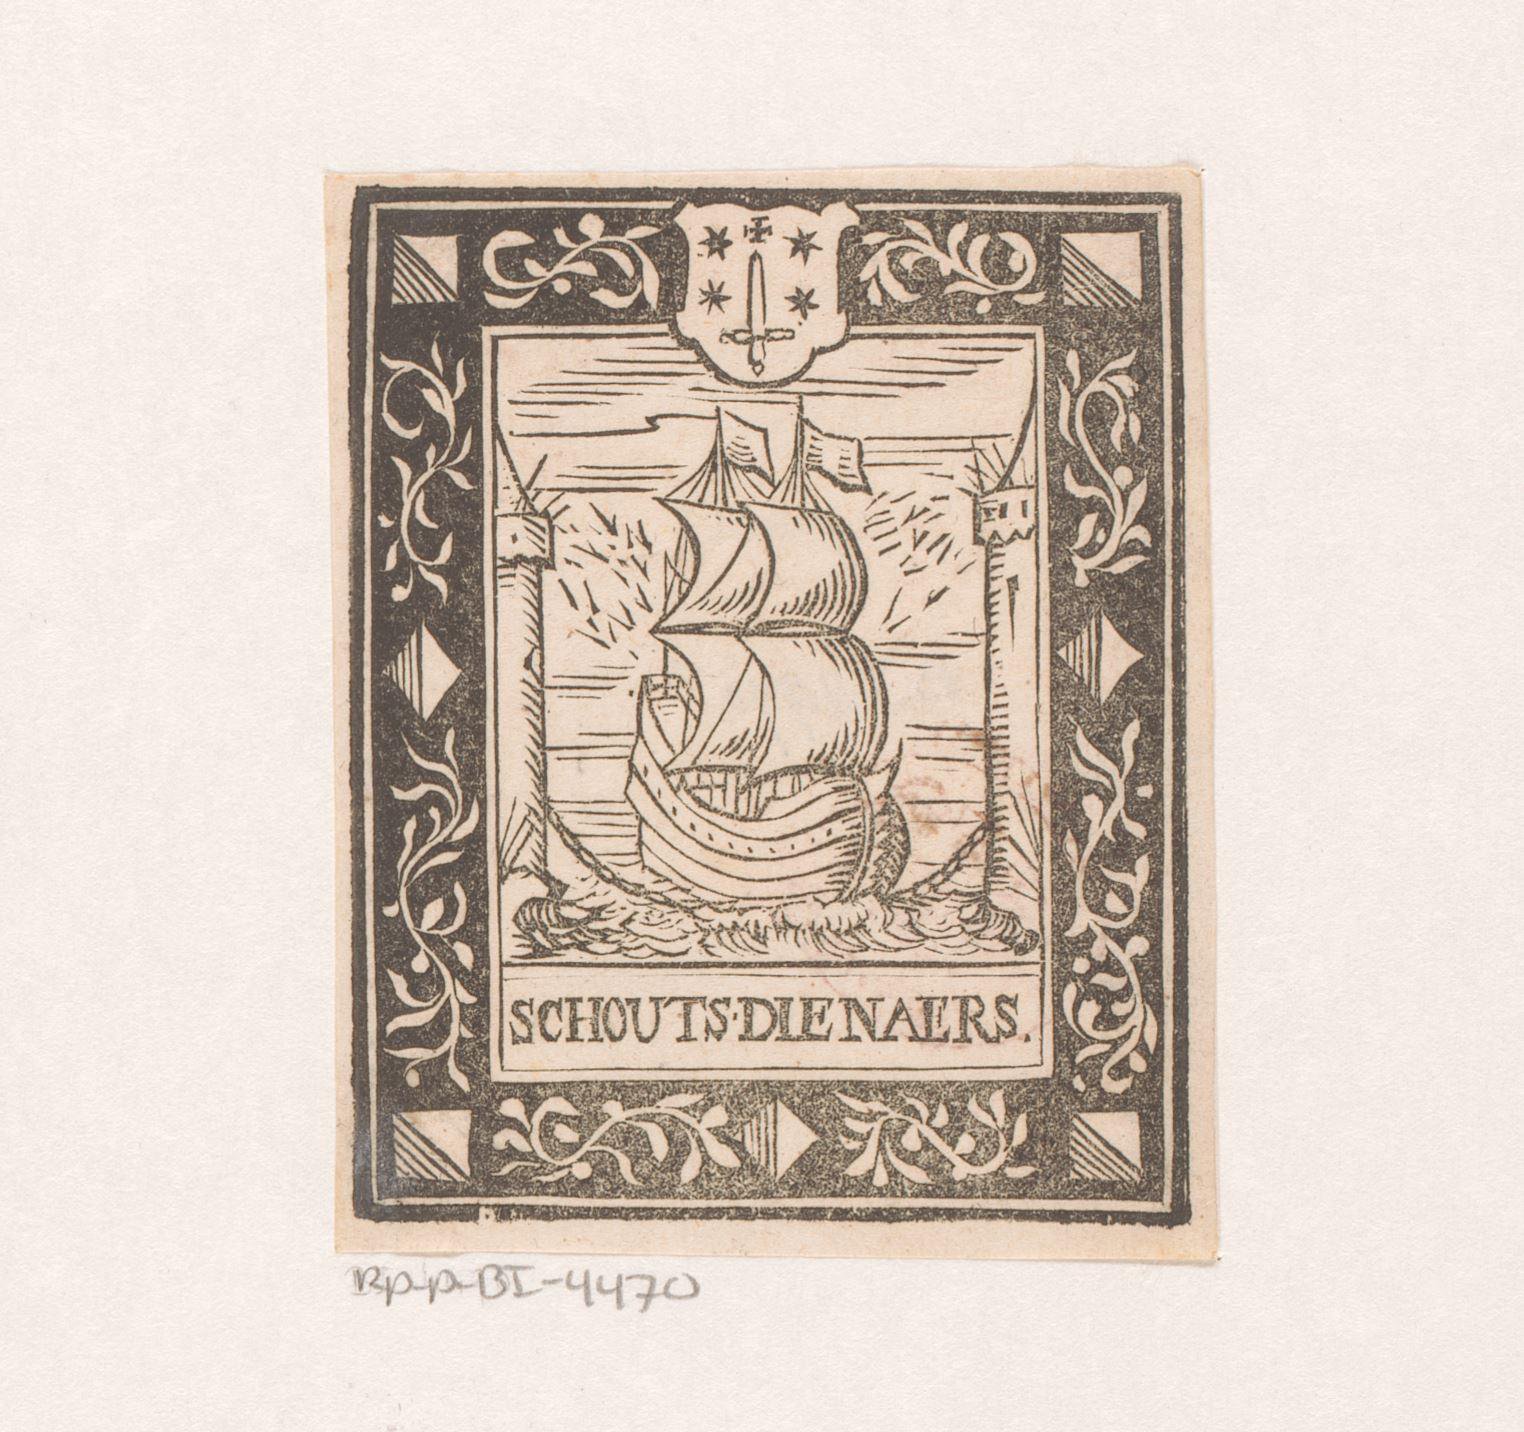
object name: print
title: Vignet met een belegering van een schip en het wapen van de stad Haarlem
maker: Anonymous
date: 1600-1699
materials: paper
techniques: woodcut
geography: netherlands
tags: coat of arms (as symbol of the state, etc.) (+ city; municipal), ships (in general), attack ~ siege, vignette, haarlem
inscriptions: collector's mark: Lugt 240